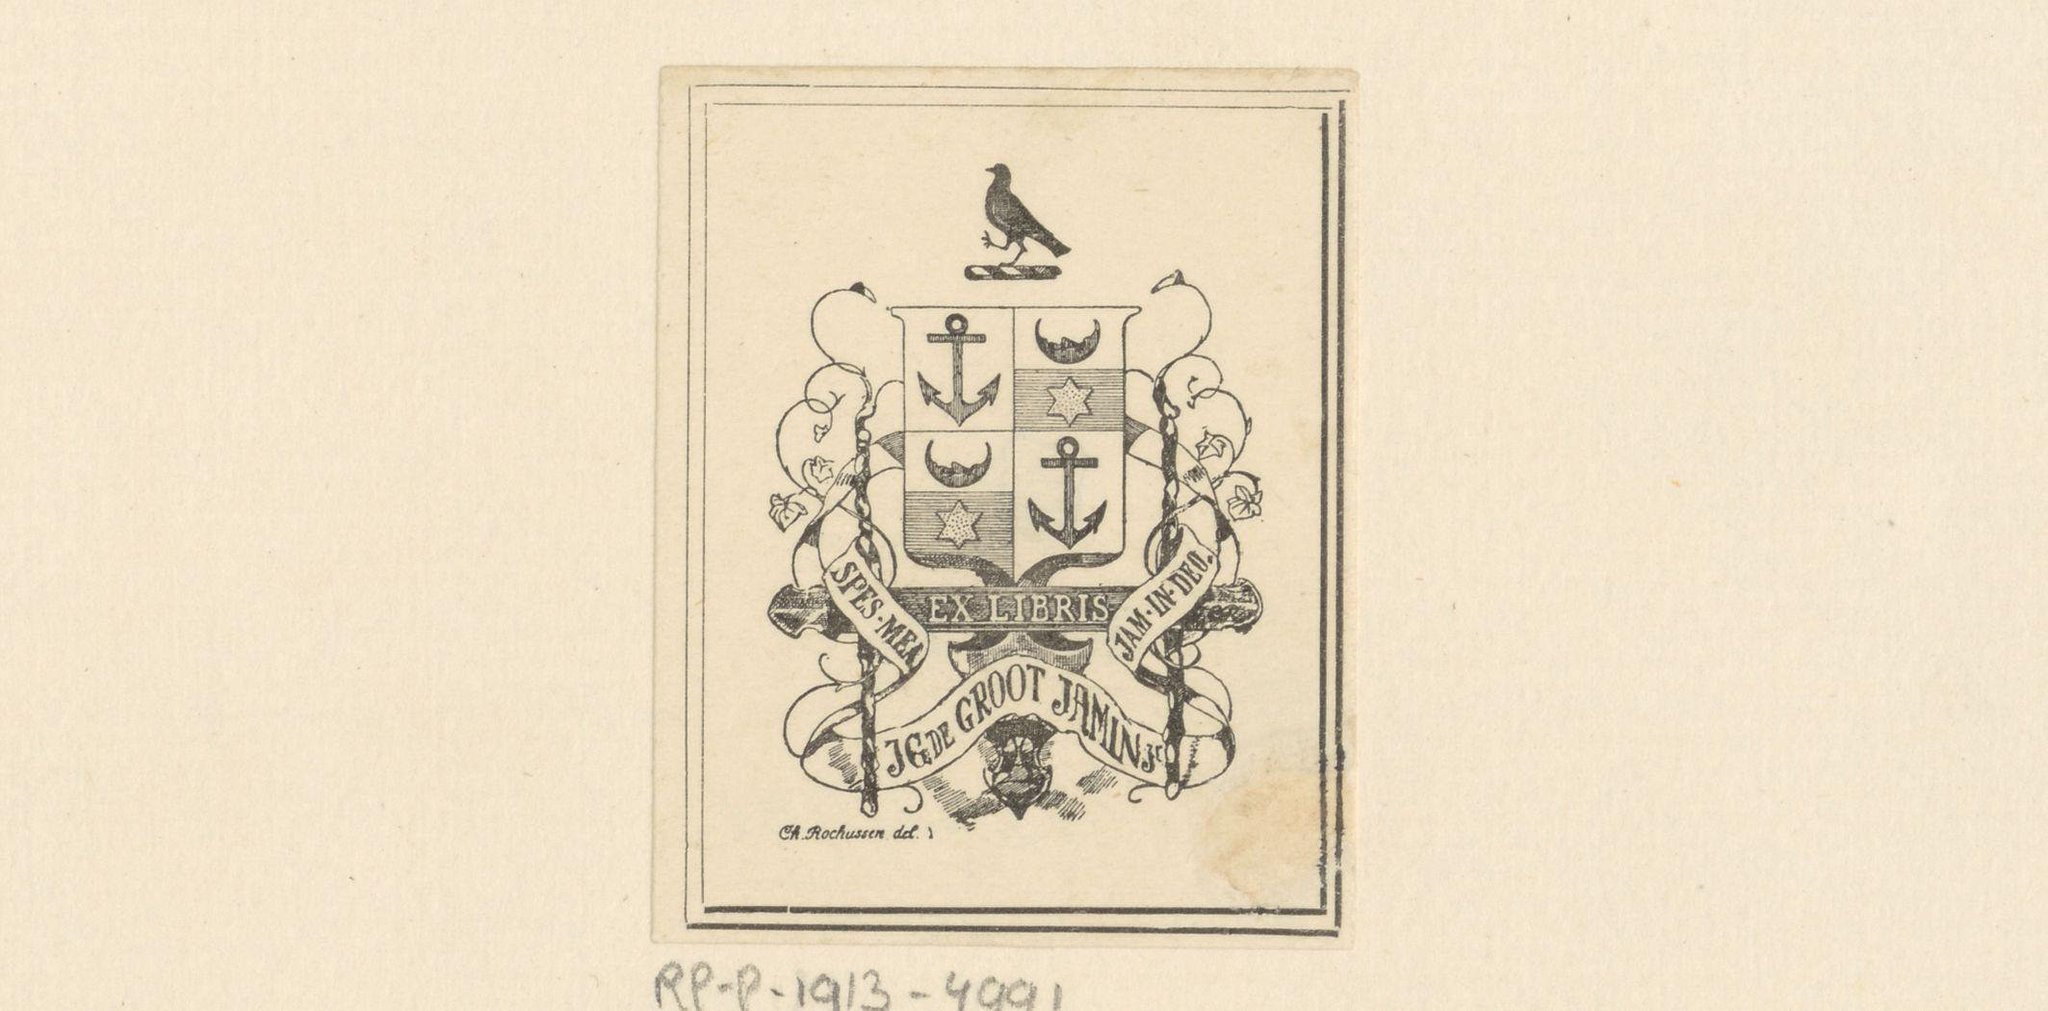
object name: bookplate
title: Ex libris van J.G. de Groot Jamin jr.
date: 1894-1913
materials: paper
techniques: printing block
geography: netherlands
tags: joannes gerardus de groot jamin jr., armorial bearing, heraldry, plants and herbs: ivy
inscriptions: collector's mark: Lugt 2760, collector's mark: Lugt 2233